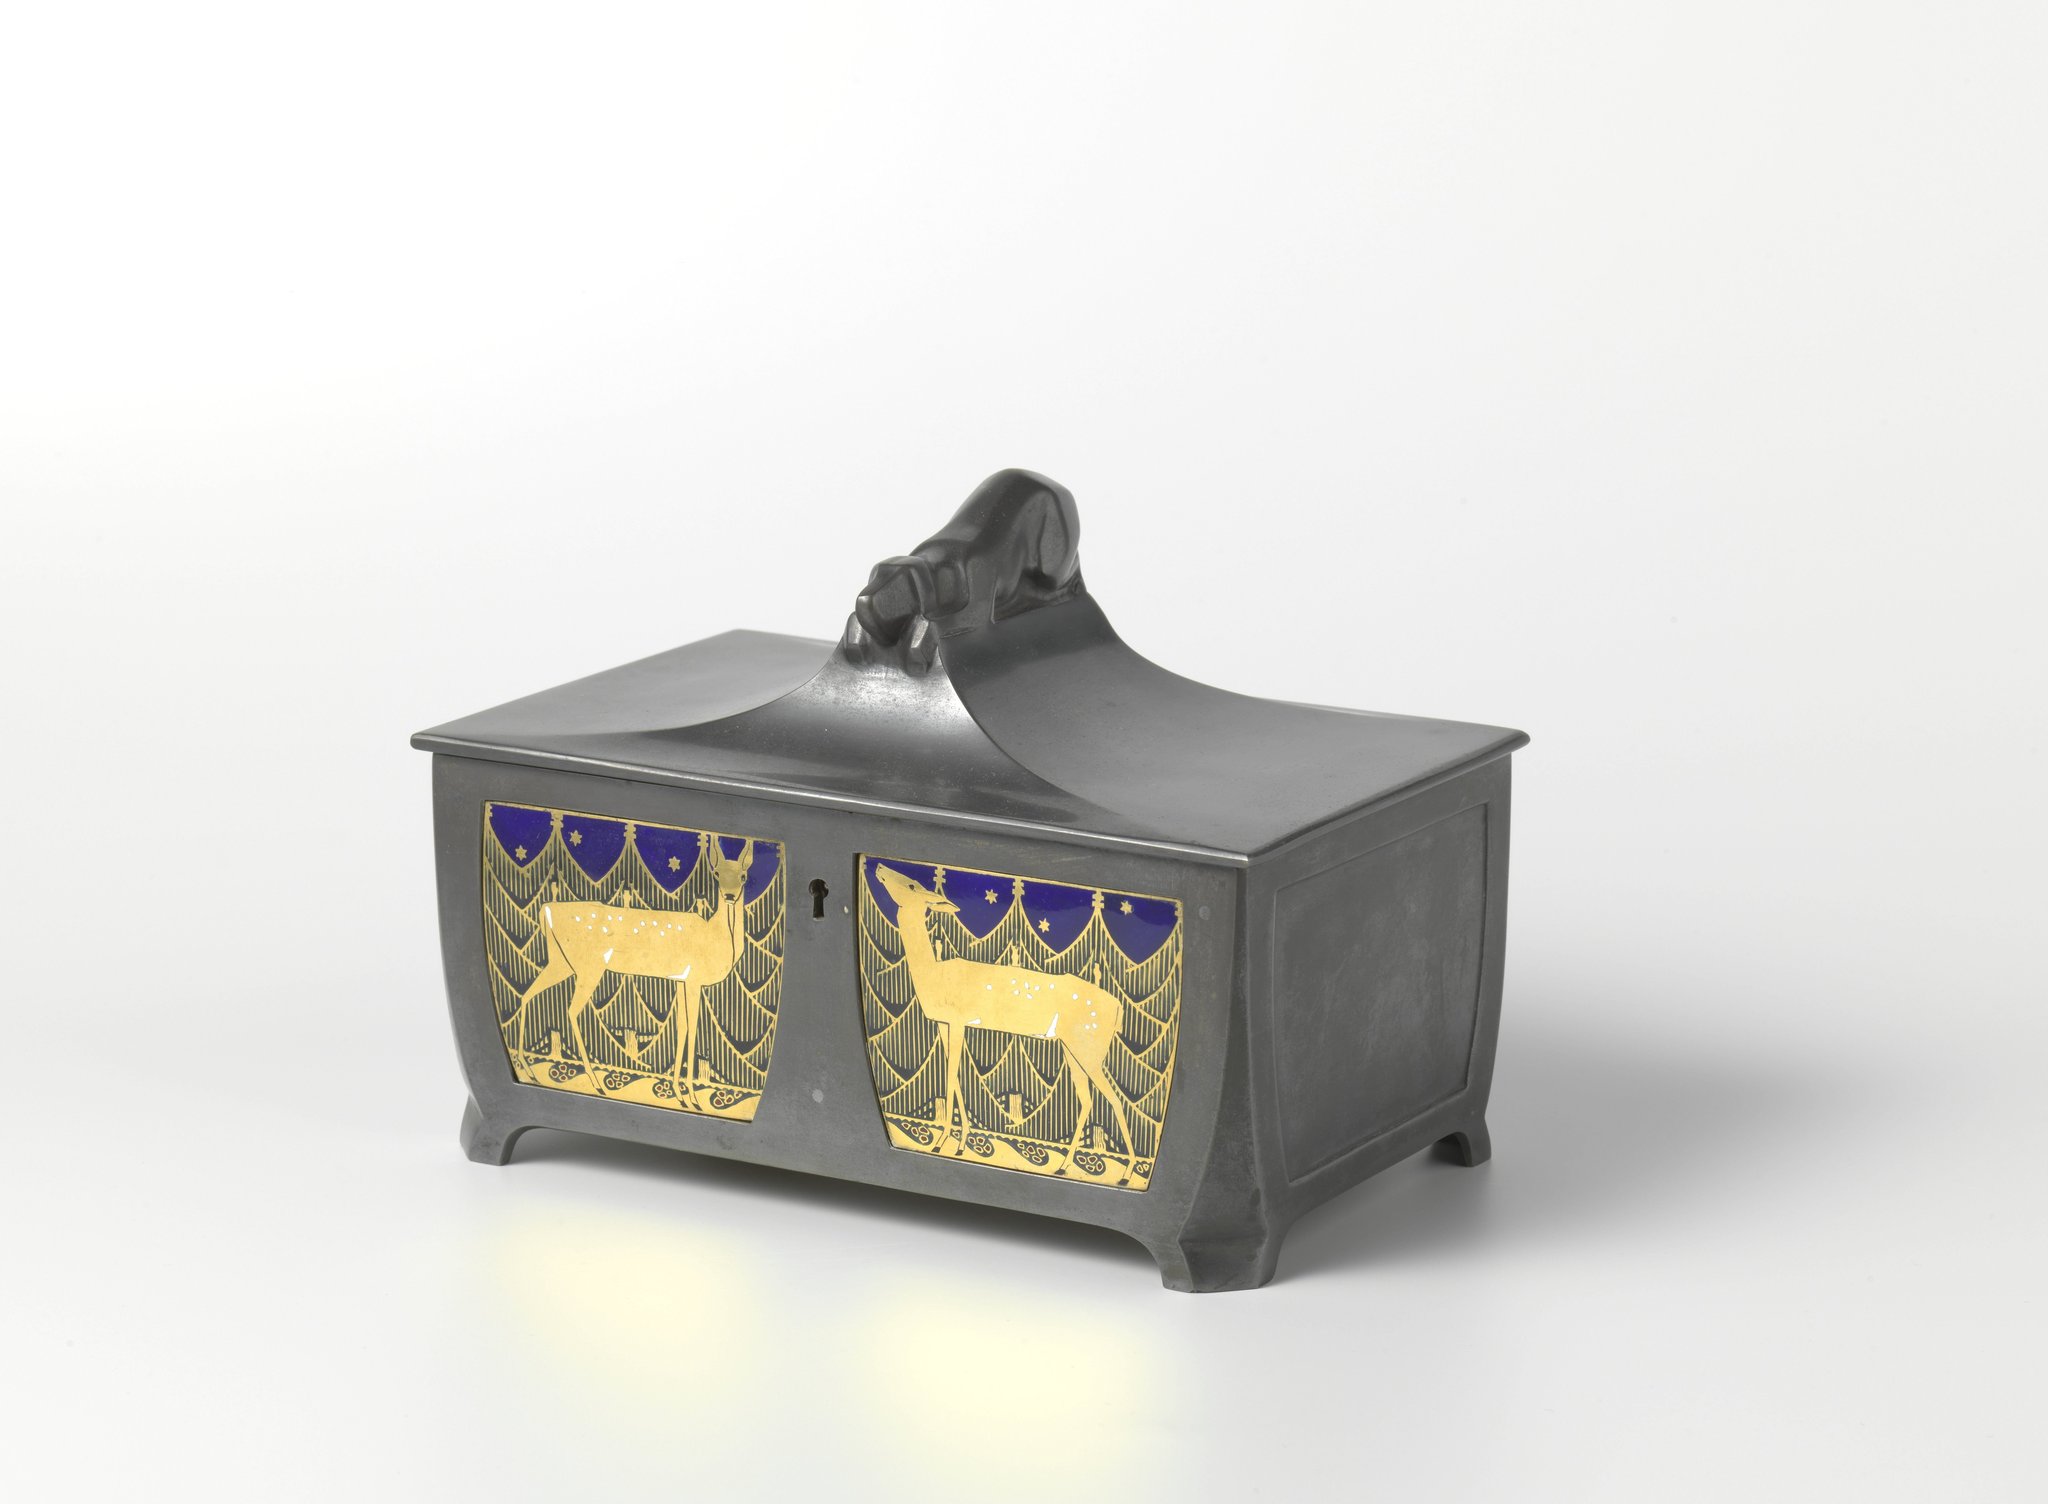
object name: chest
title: Kist van ijzer, aan de voorzijde gedecoreerd met twee verguld koperen plaques met reeën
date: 1908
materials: copper, iron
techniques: gilding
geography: darmstadt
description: Box. Iron, inlaid with plaques of gilt and enamelled copper. Darmstadt, c. 1908, designed by Albin Müller.